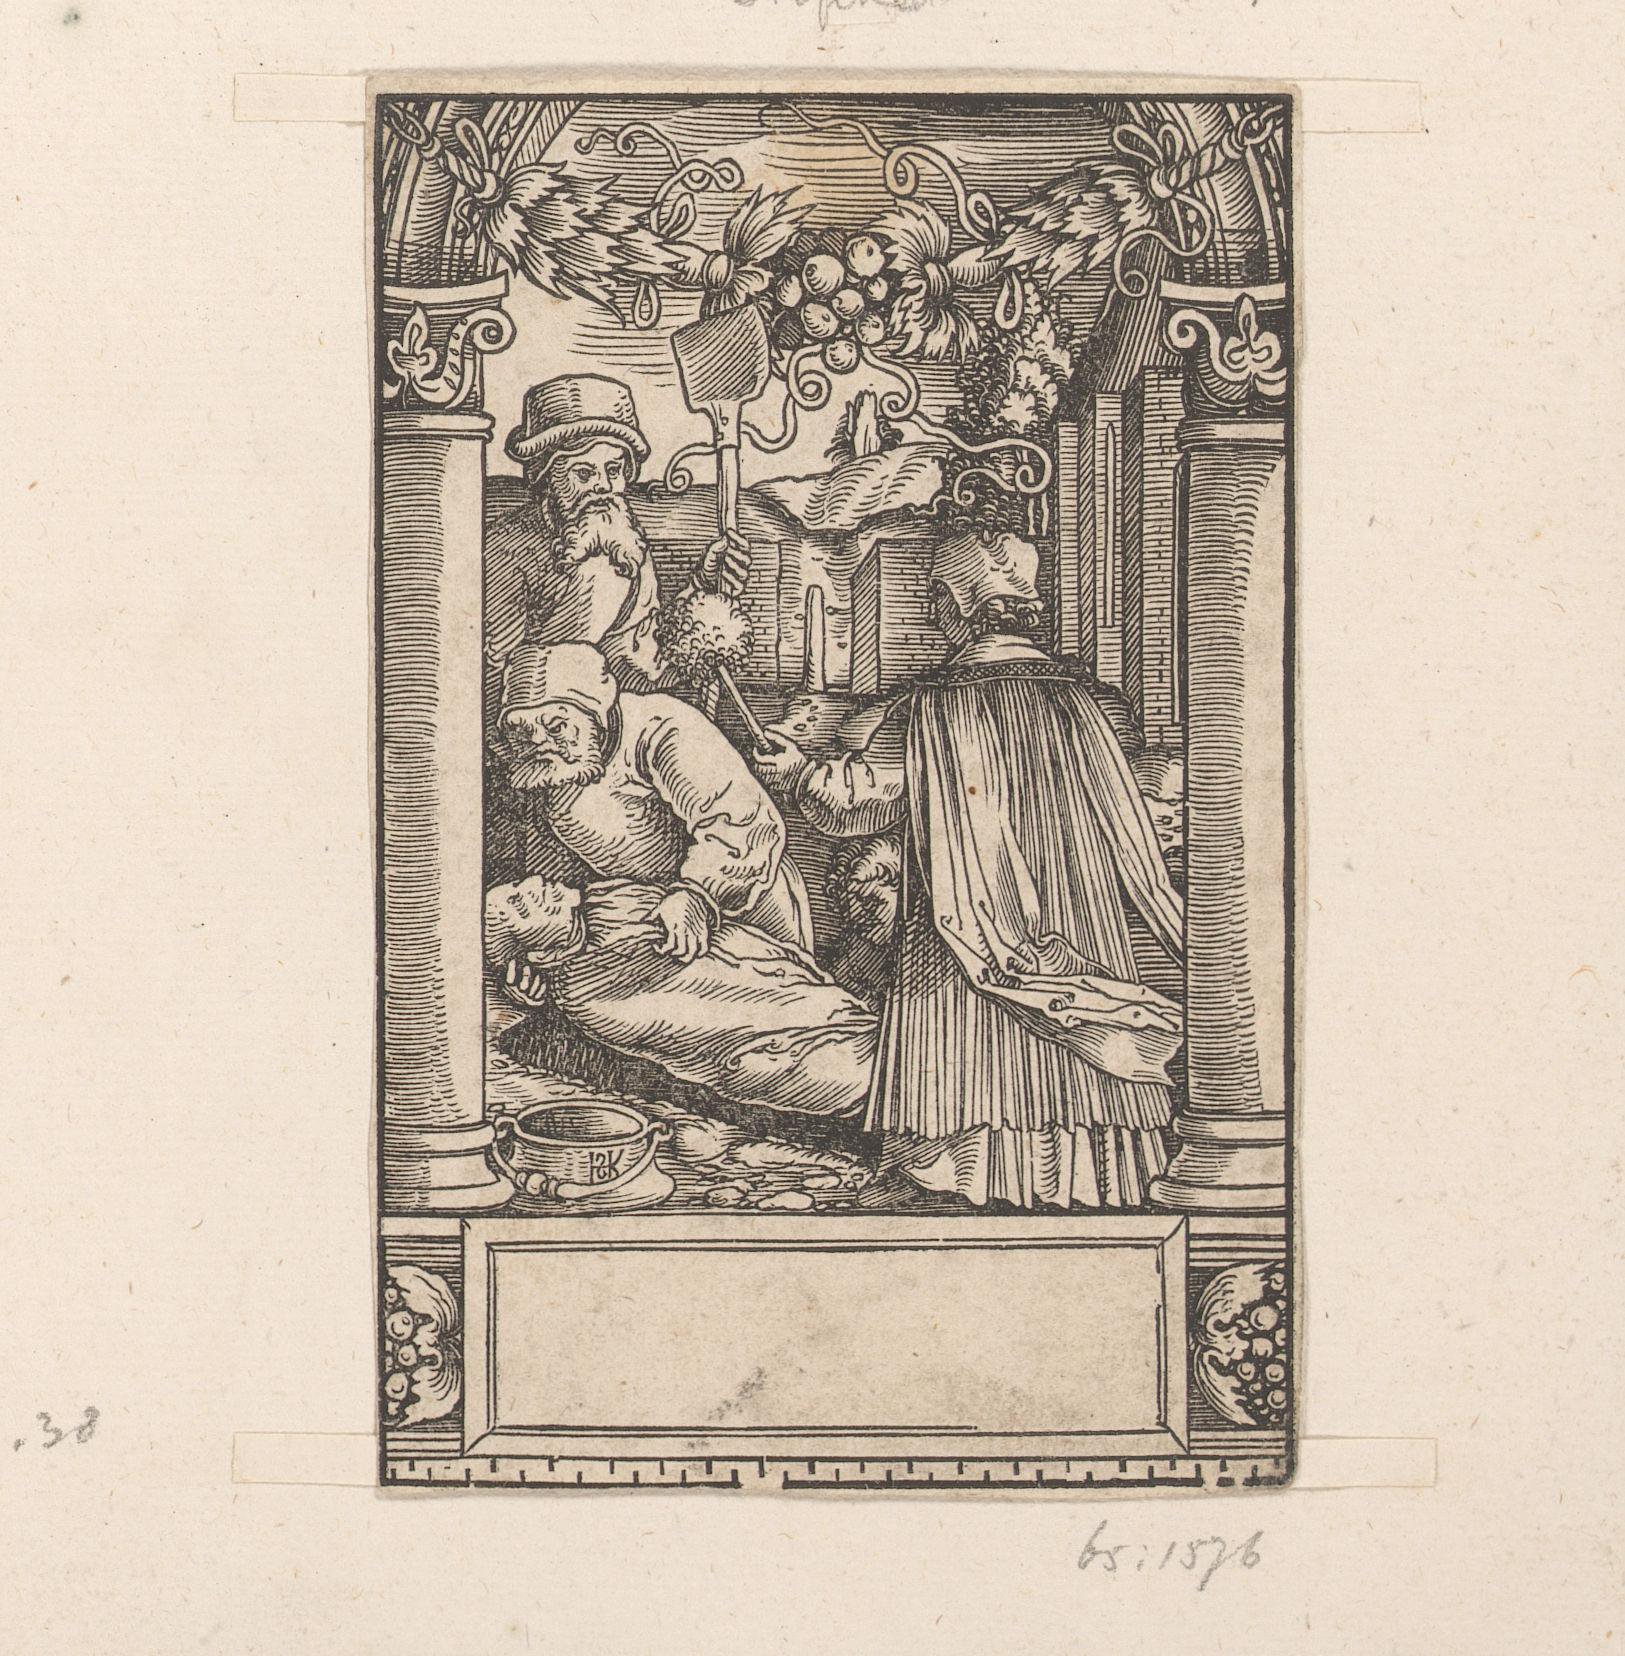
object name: album leaf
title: Begrafenis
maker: hans springinklee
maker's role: print maker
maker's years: -1540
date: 1518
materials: paper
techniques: woodcut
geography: nuremberg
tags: burial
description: Een dode wordt in een graf gelegd. De priester besprenkeld de dode met wijwater. Prent maakt deel uit van een album.